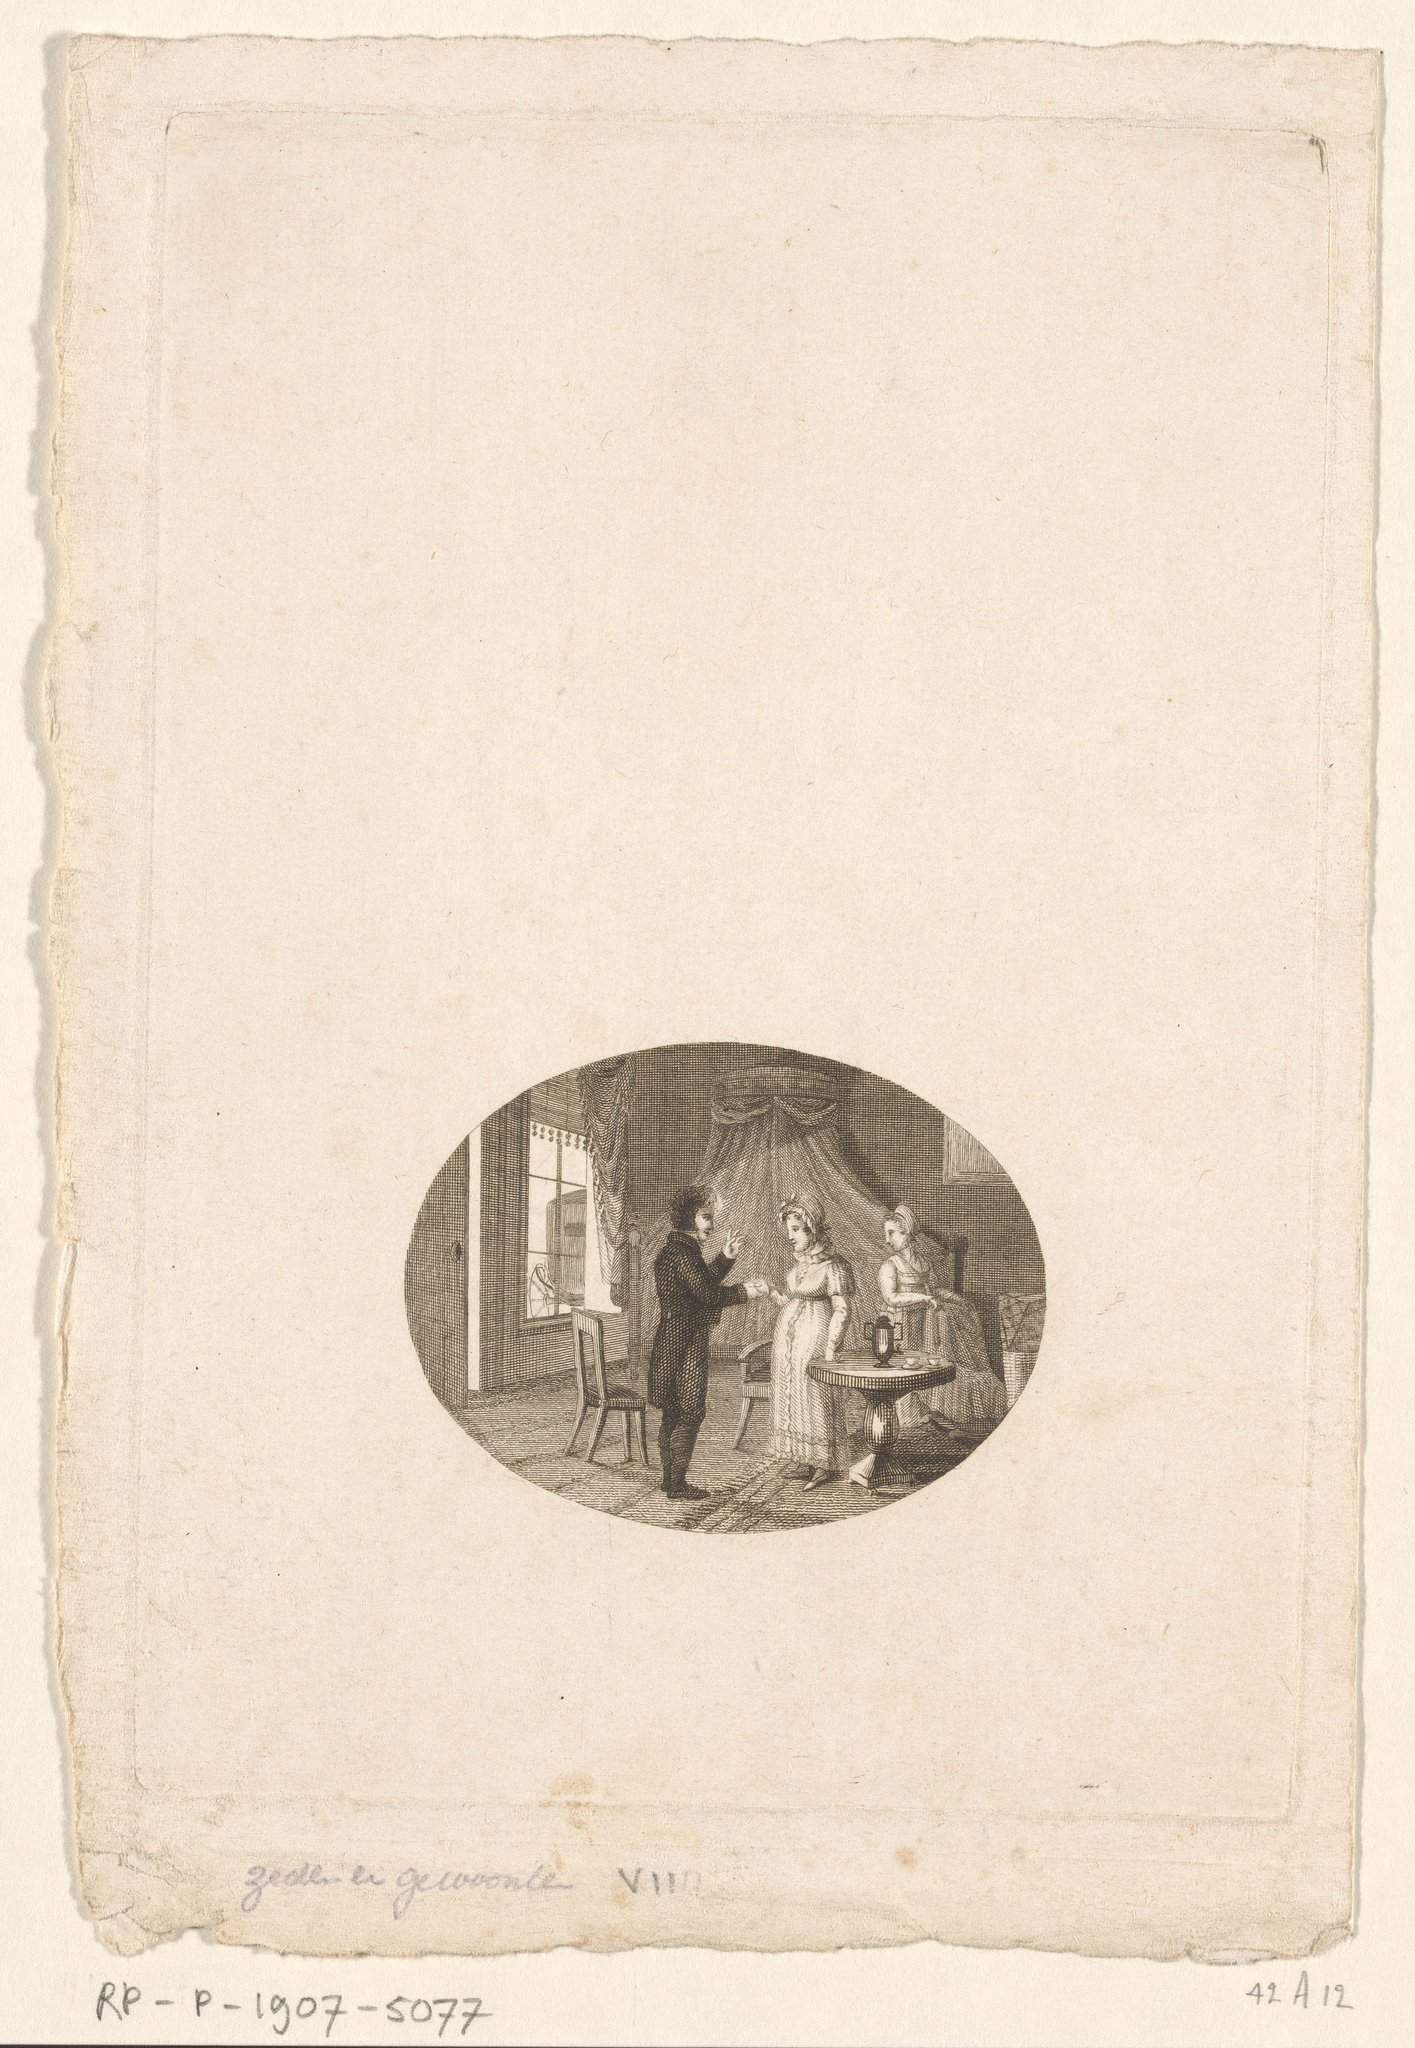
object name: print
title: Interieur met een man, een zwangere vrouw en dienstmeid bij een tafel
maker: Anonymous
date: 1800-1899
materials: paper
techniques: etching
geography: netherlands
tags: pregnant woman, pregnancy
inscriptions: collector's mark: Lugt 2228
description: Betreft mogelijk een prent voor een onbekend boek.